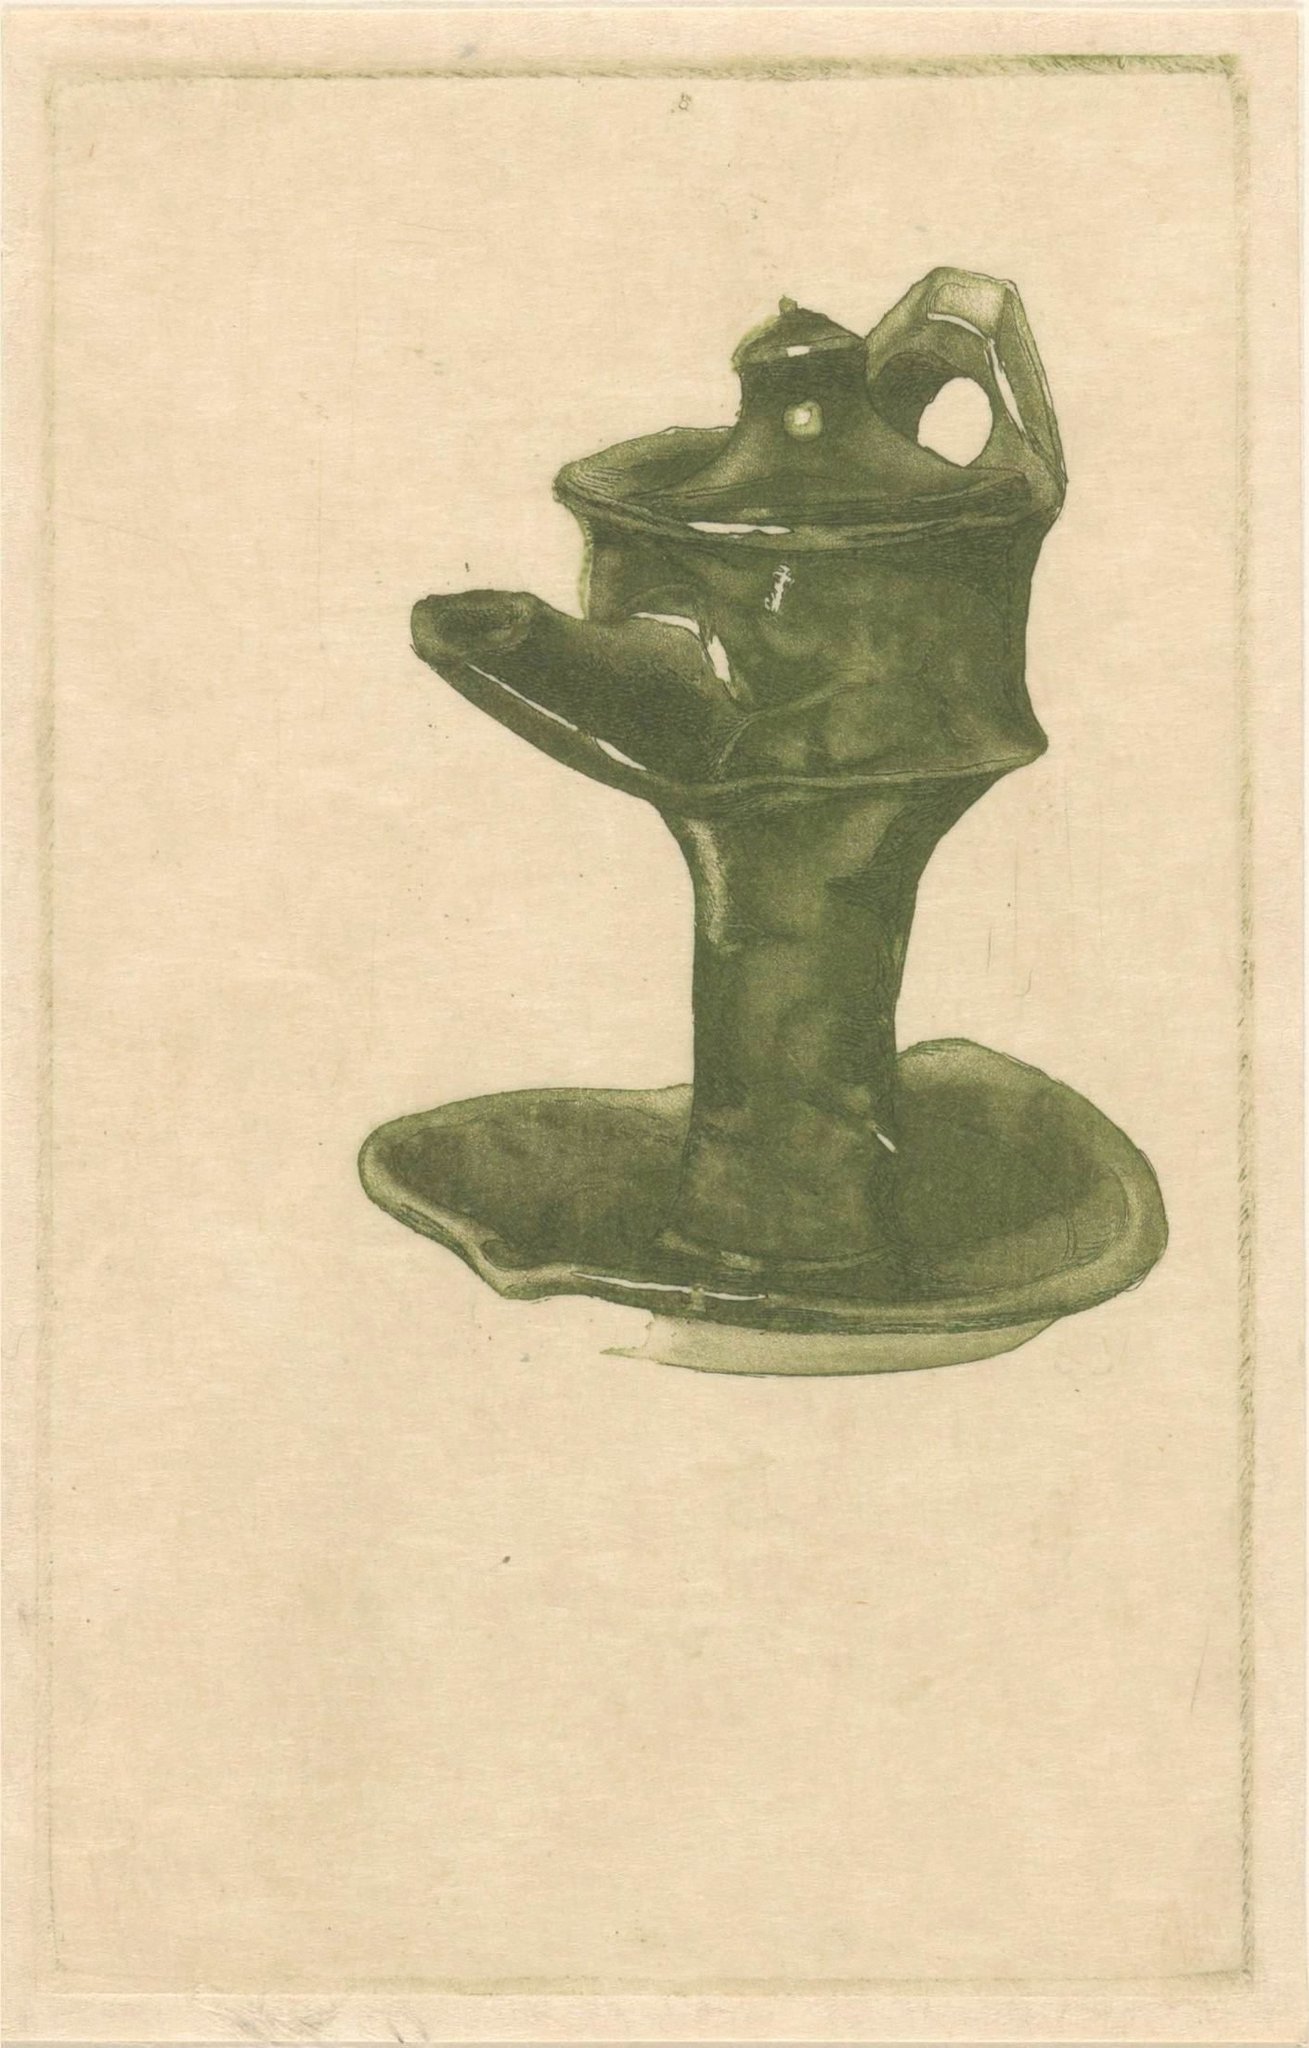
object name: print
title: Schenkkan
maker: frans everbag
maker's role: draughtsman, print maker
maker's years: 1877-1947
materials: paper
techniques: aquatint, etching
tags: container of ceramics: jar, jug, pot, vase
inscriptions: collector's mark: Lugt 2228